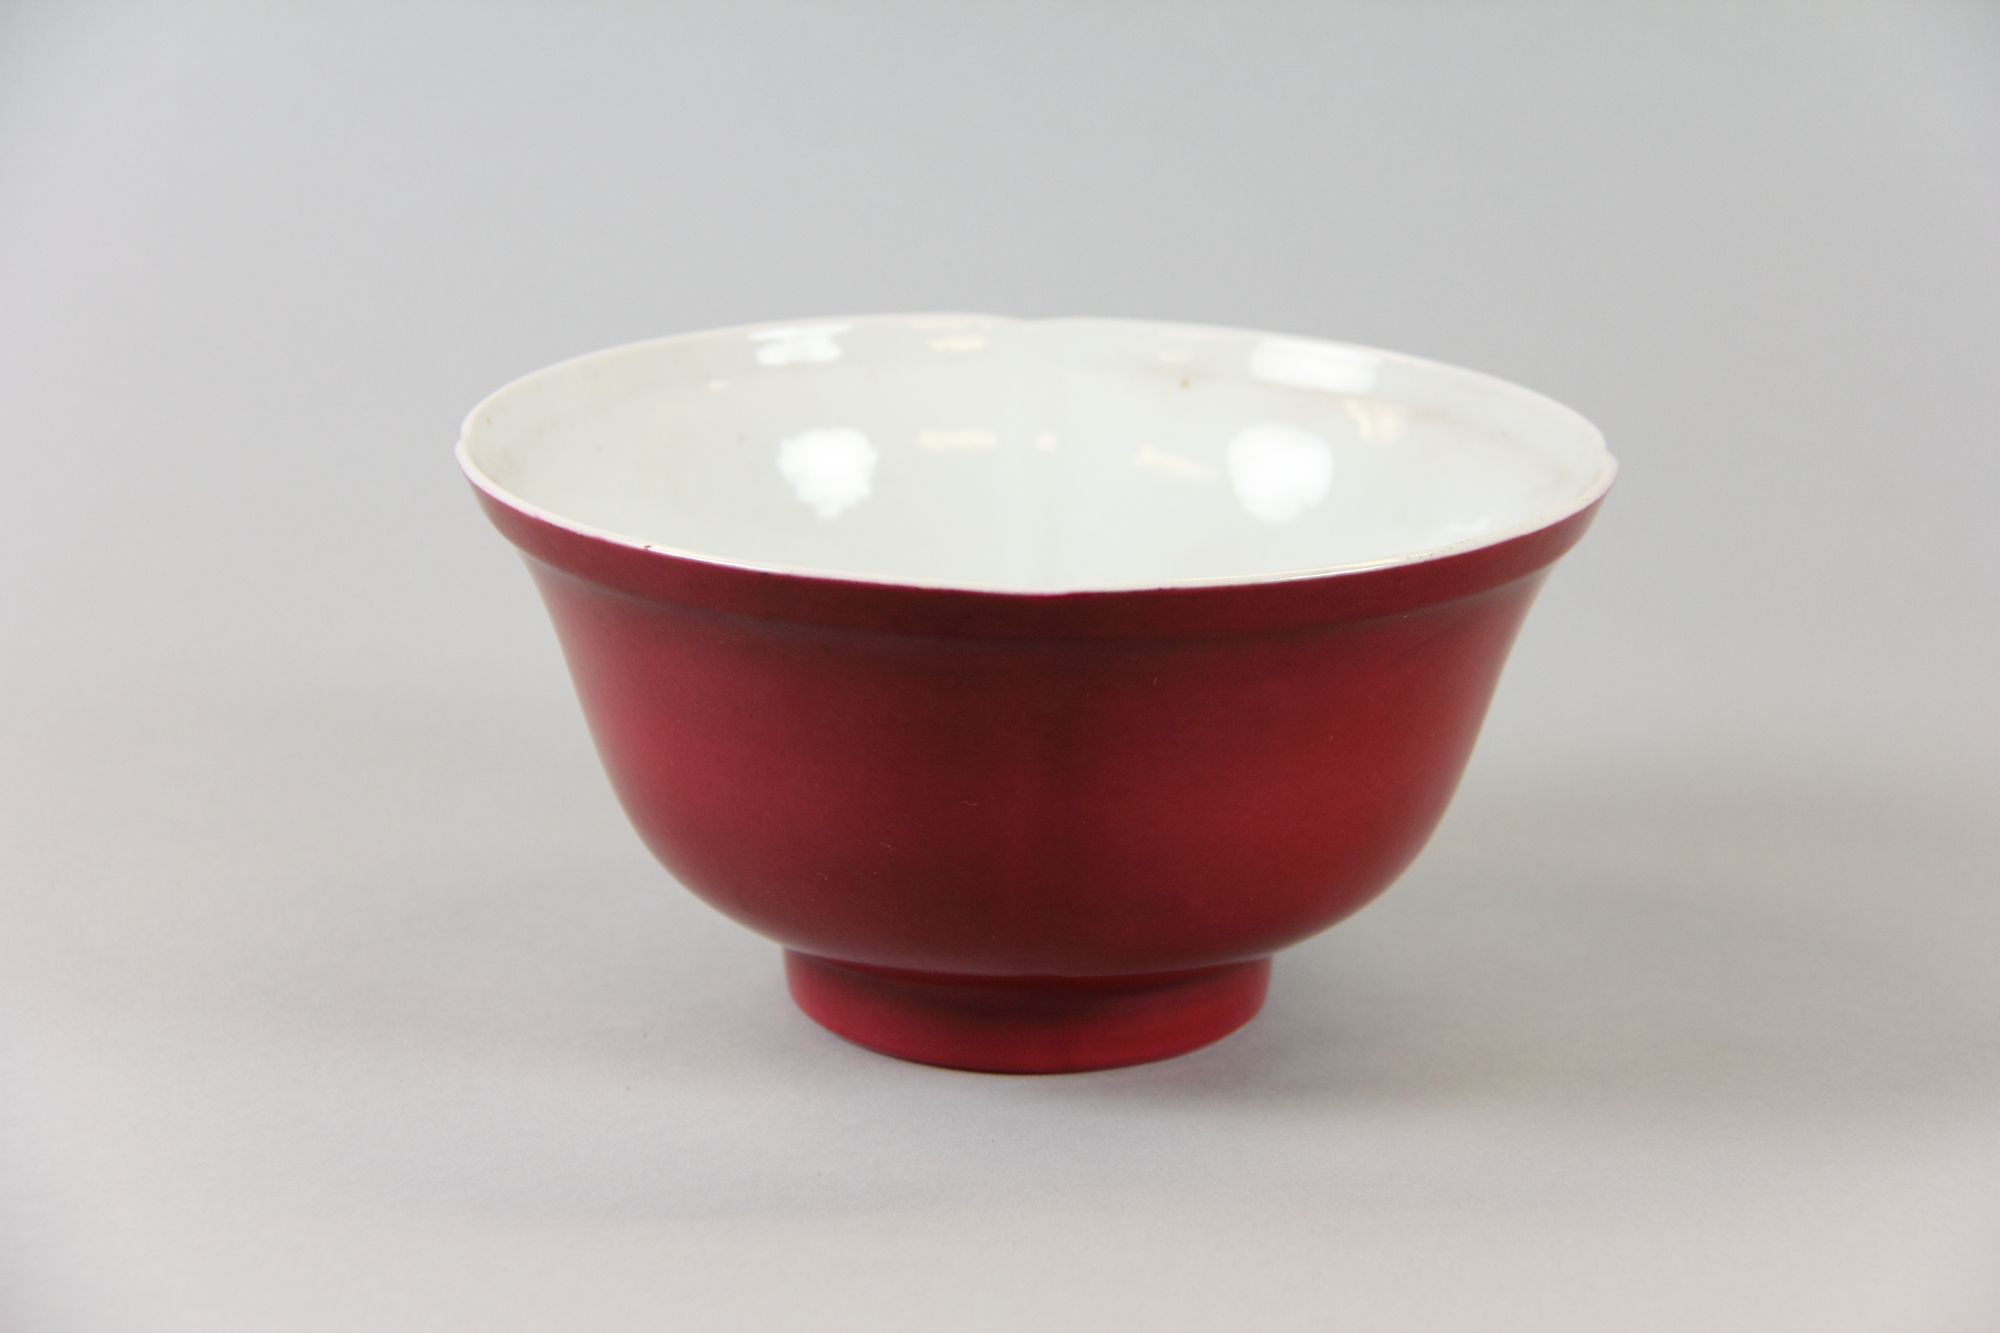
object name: bowl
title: Lobed bowl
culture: chinese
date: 1701-1733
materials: glaze, gold, porcelain